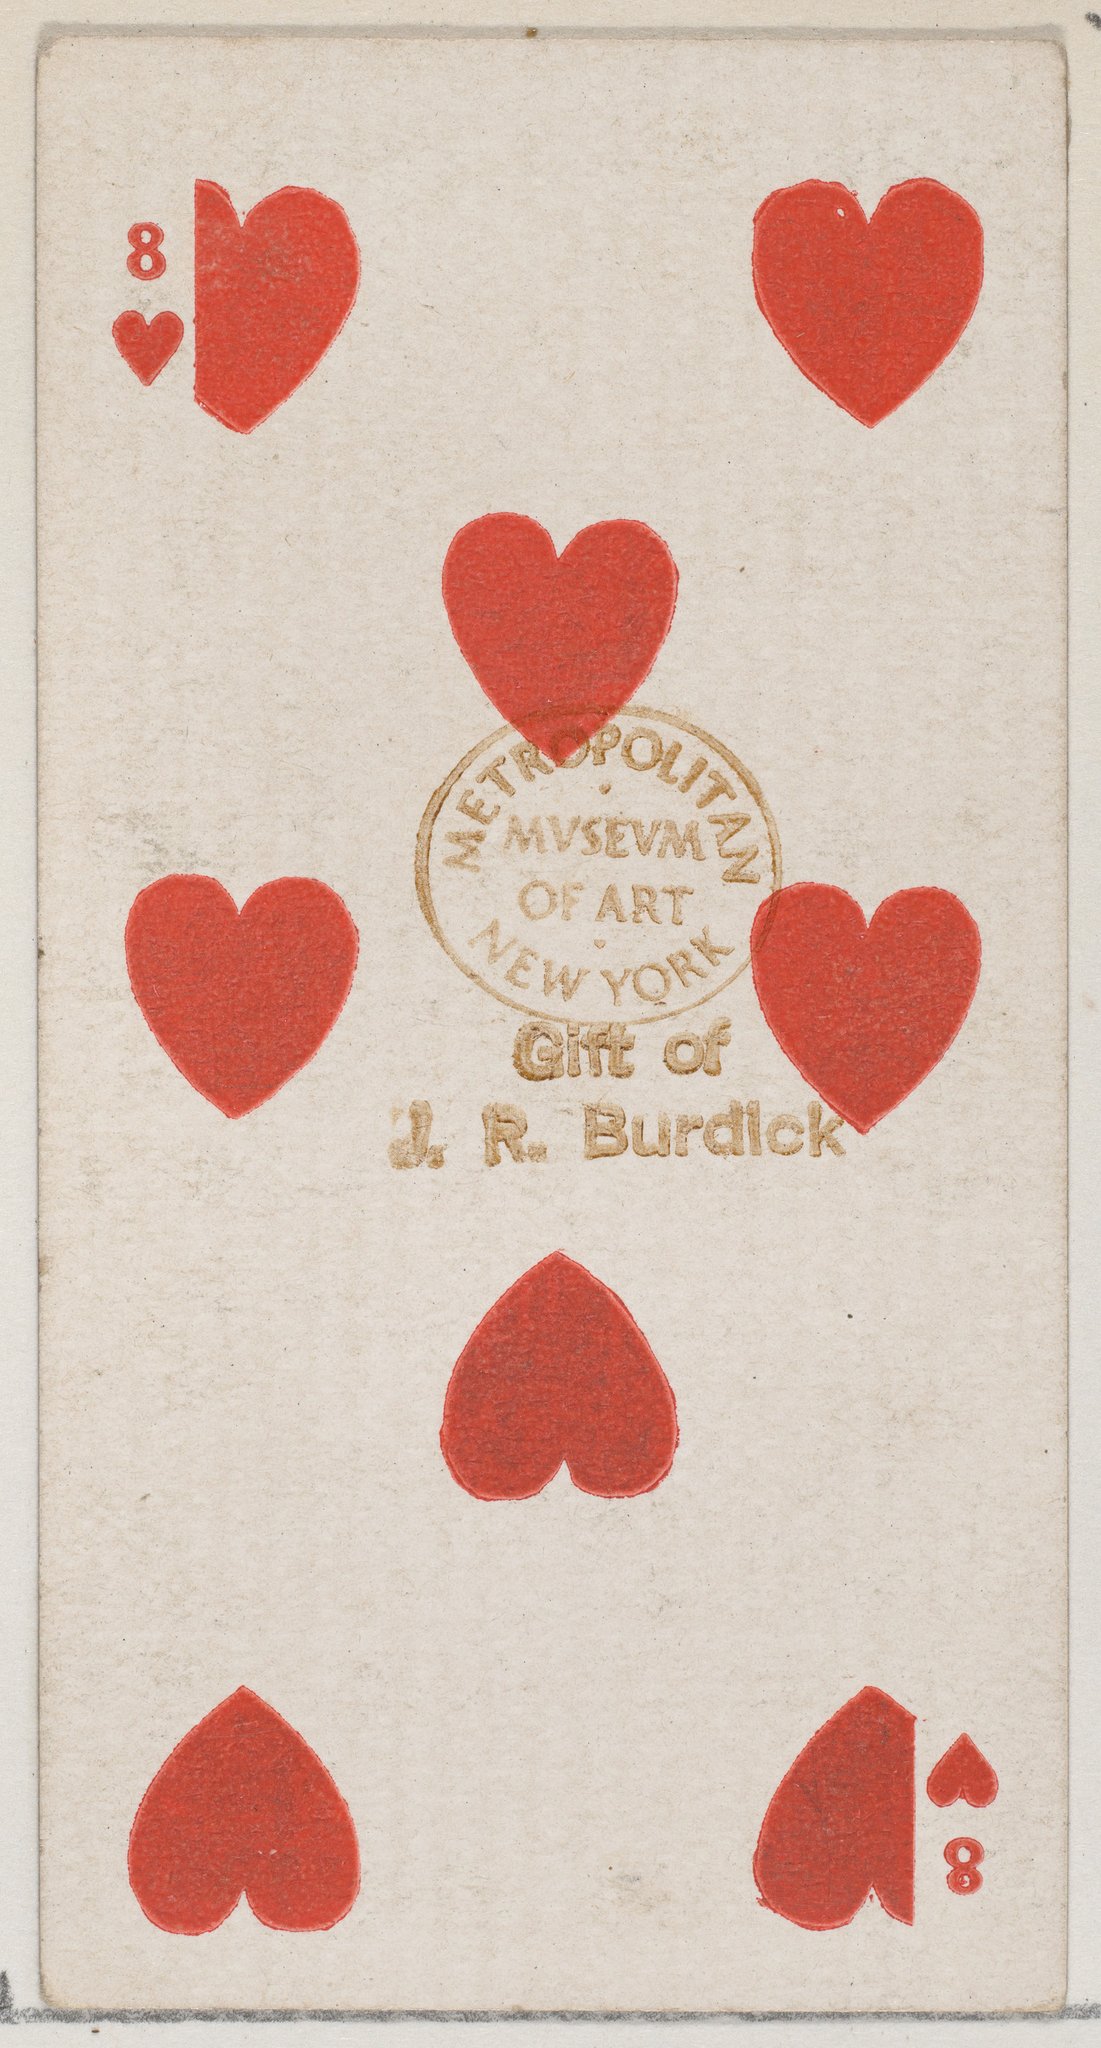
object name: print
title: Eight Hearts (red), from the Playing Cards series (N84) for Duke brand cigarettes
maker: w. duke, sons & co.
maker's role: publisher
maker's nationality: american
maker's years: 1870-1920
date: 1888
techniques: color lithograph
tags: playing cards